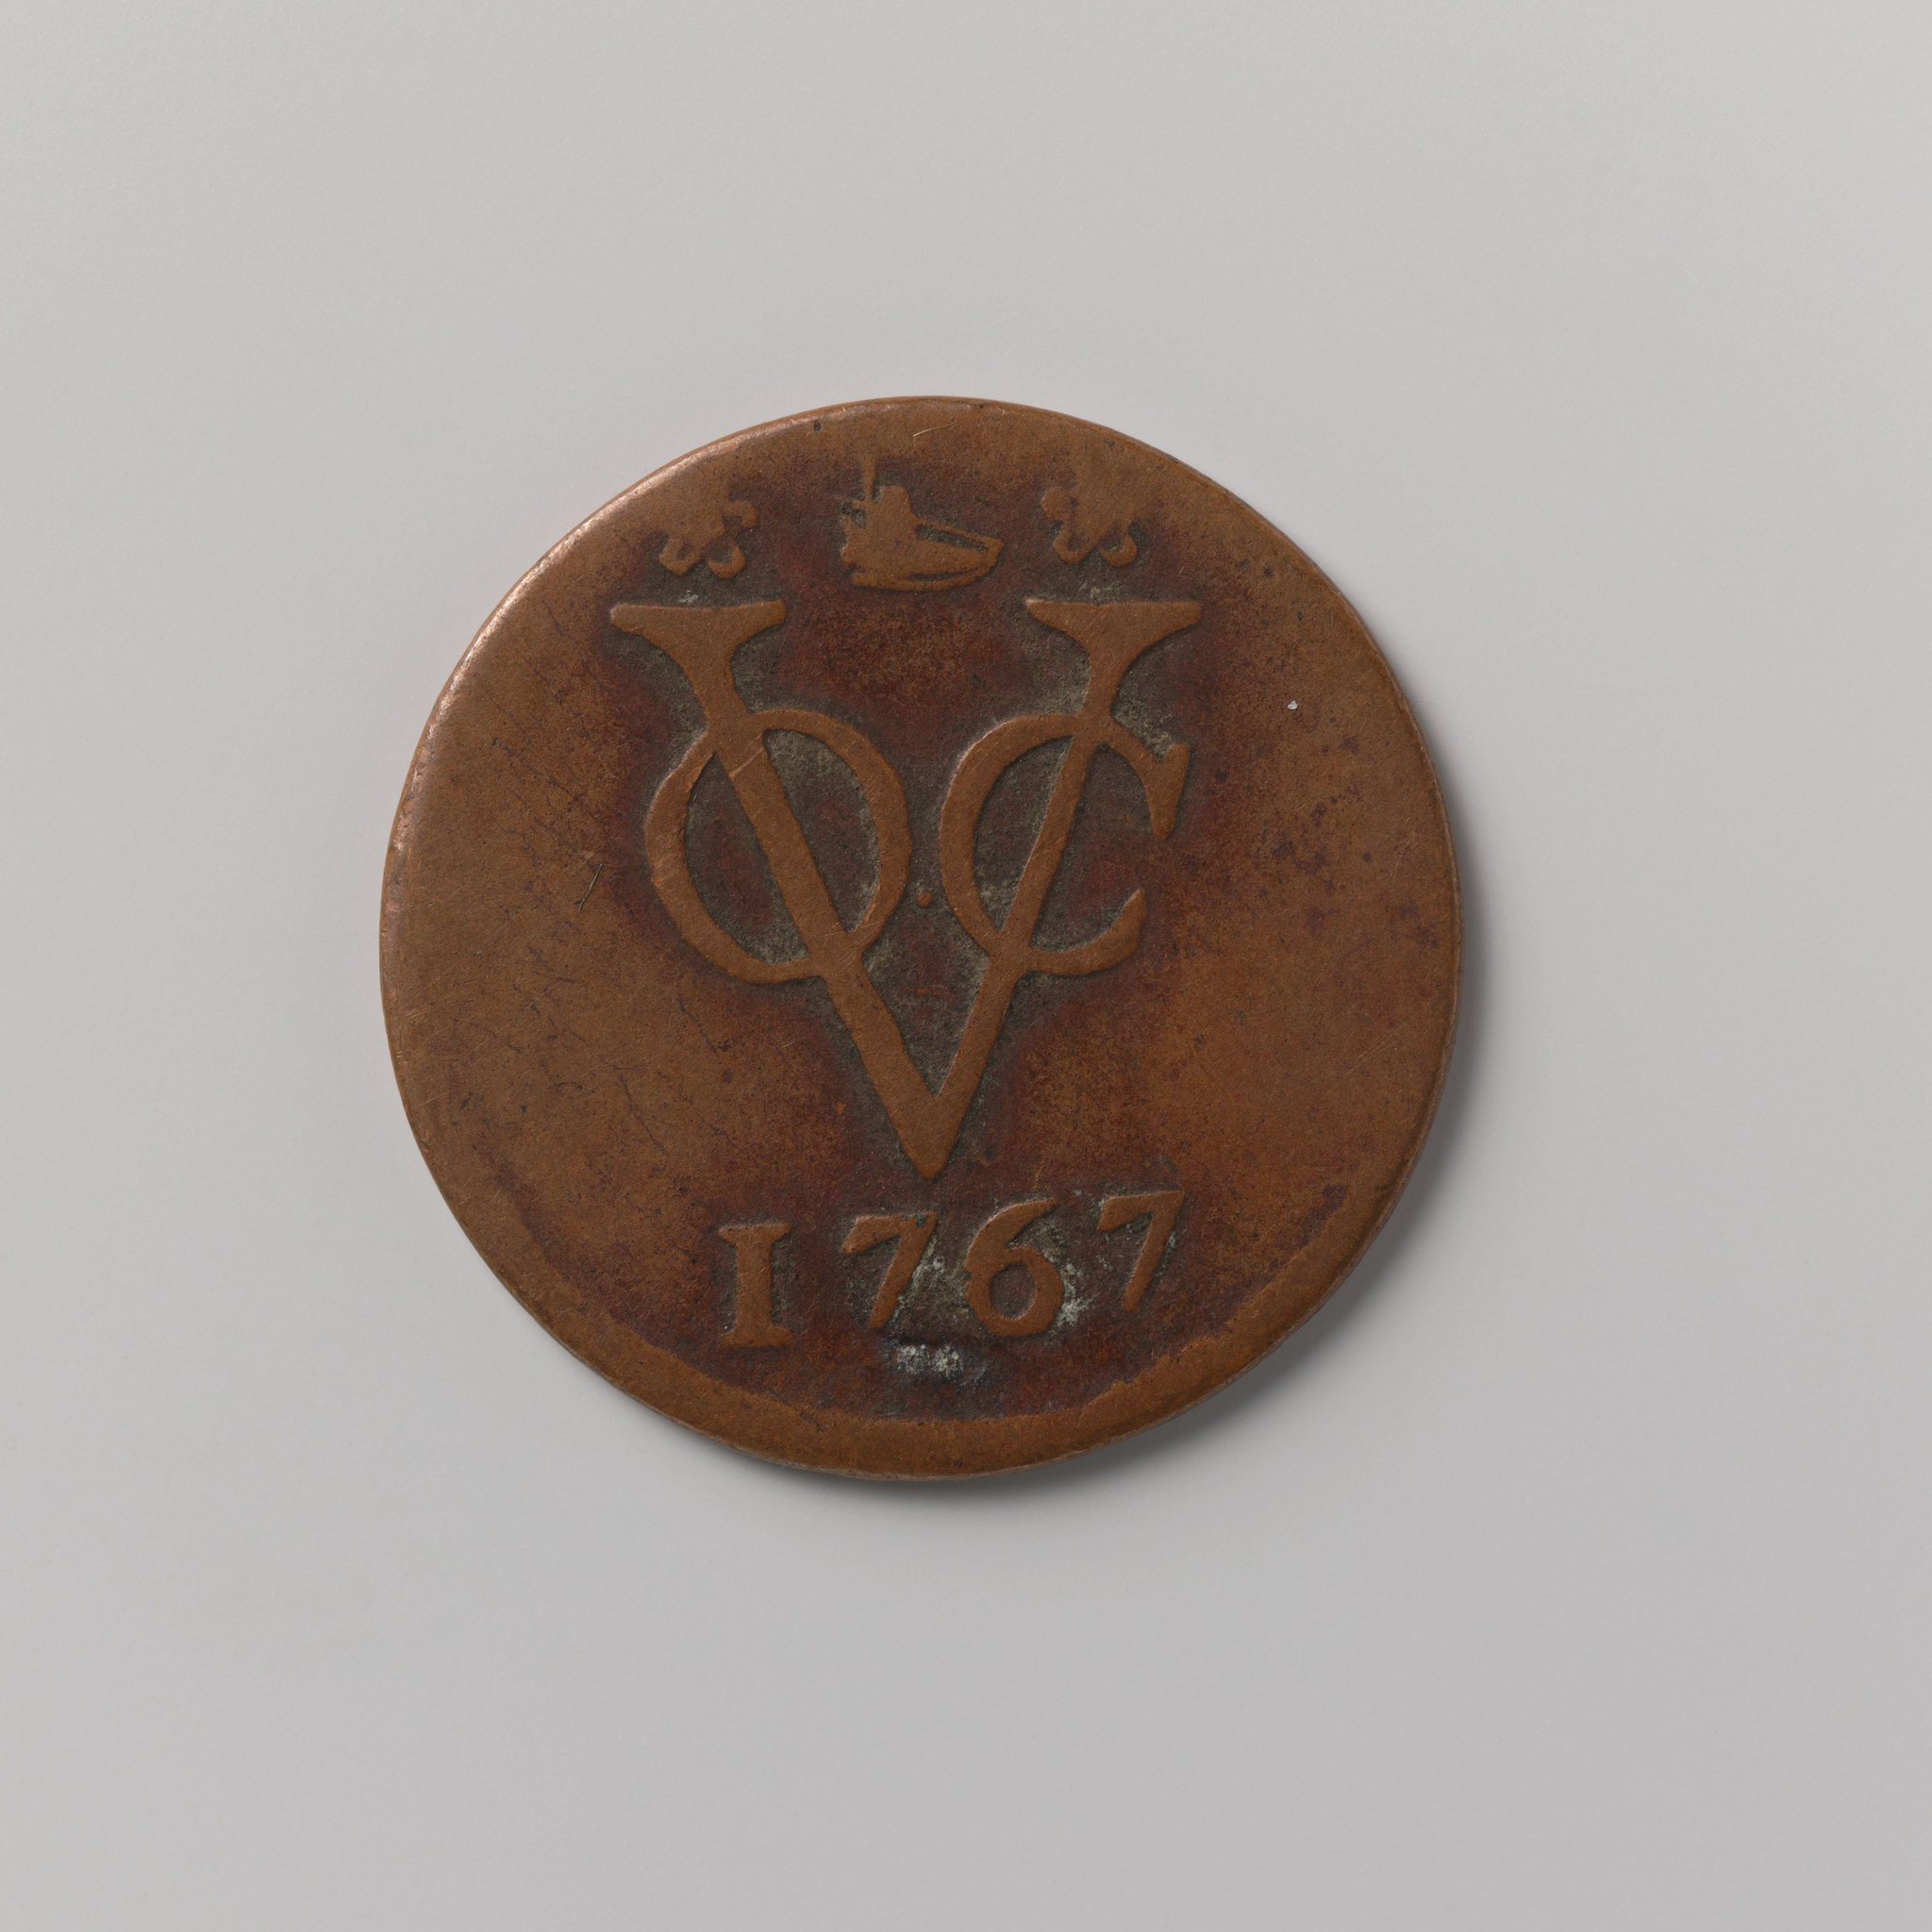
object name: coin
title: Duit van de VOC uit Westfriesland,1767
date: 1767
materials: copper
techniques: striking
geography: enkhuizen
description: Koperen munt. Voorzijde: gekroond wapenschild van Westfriesland. Keerzijde: monogram van de VOC, waarboven muntmeesterteken en waaronder jaartal. Gladde rand.